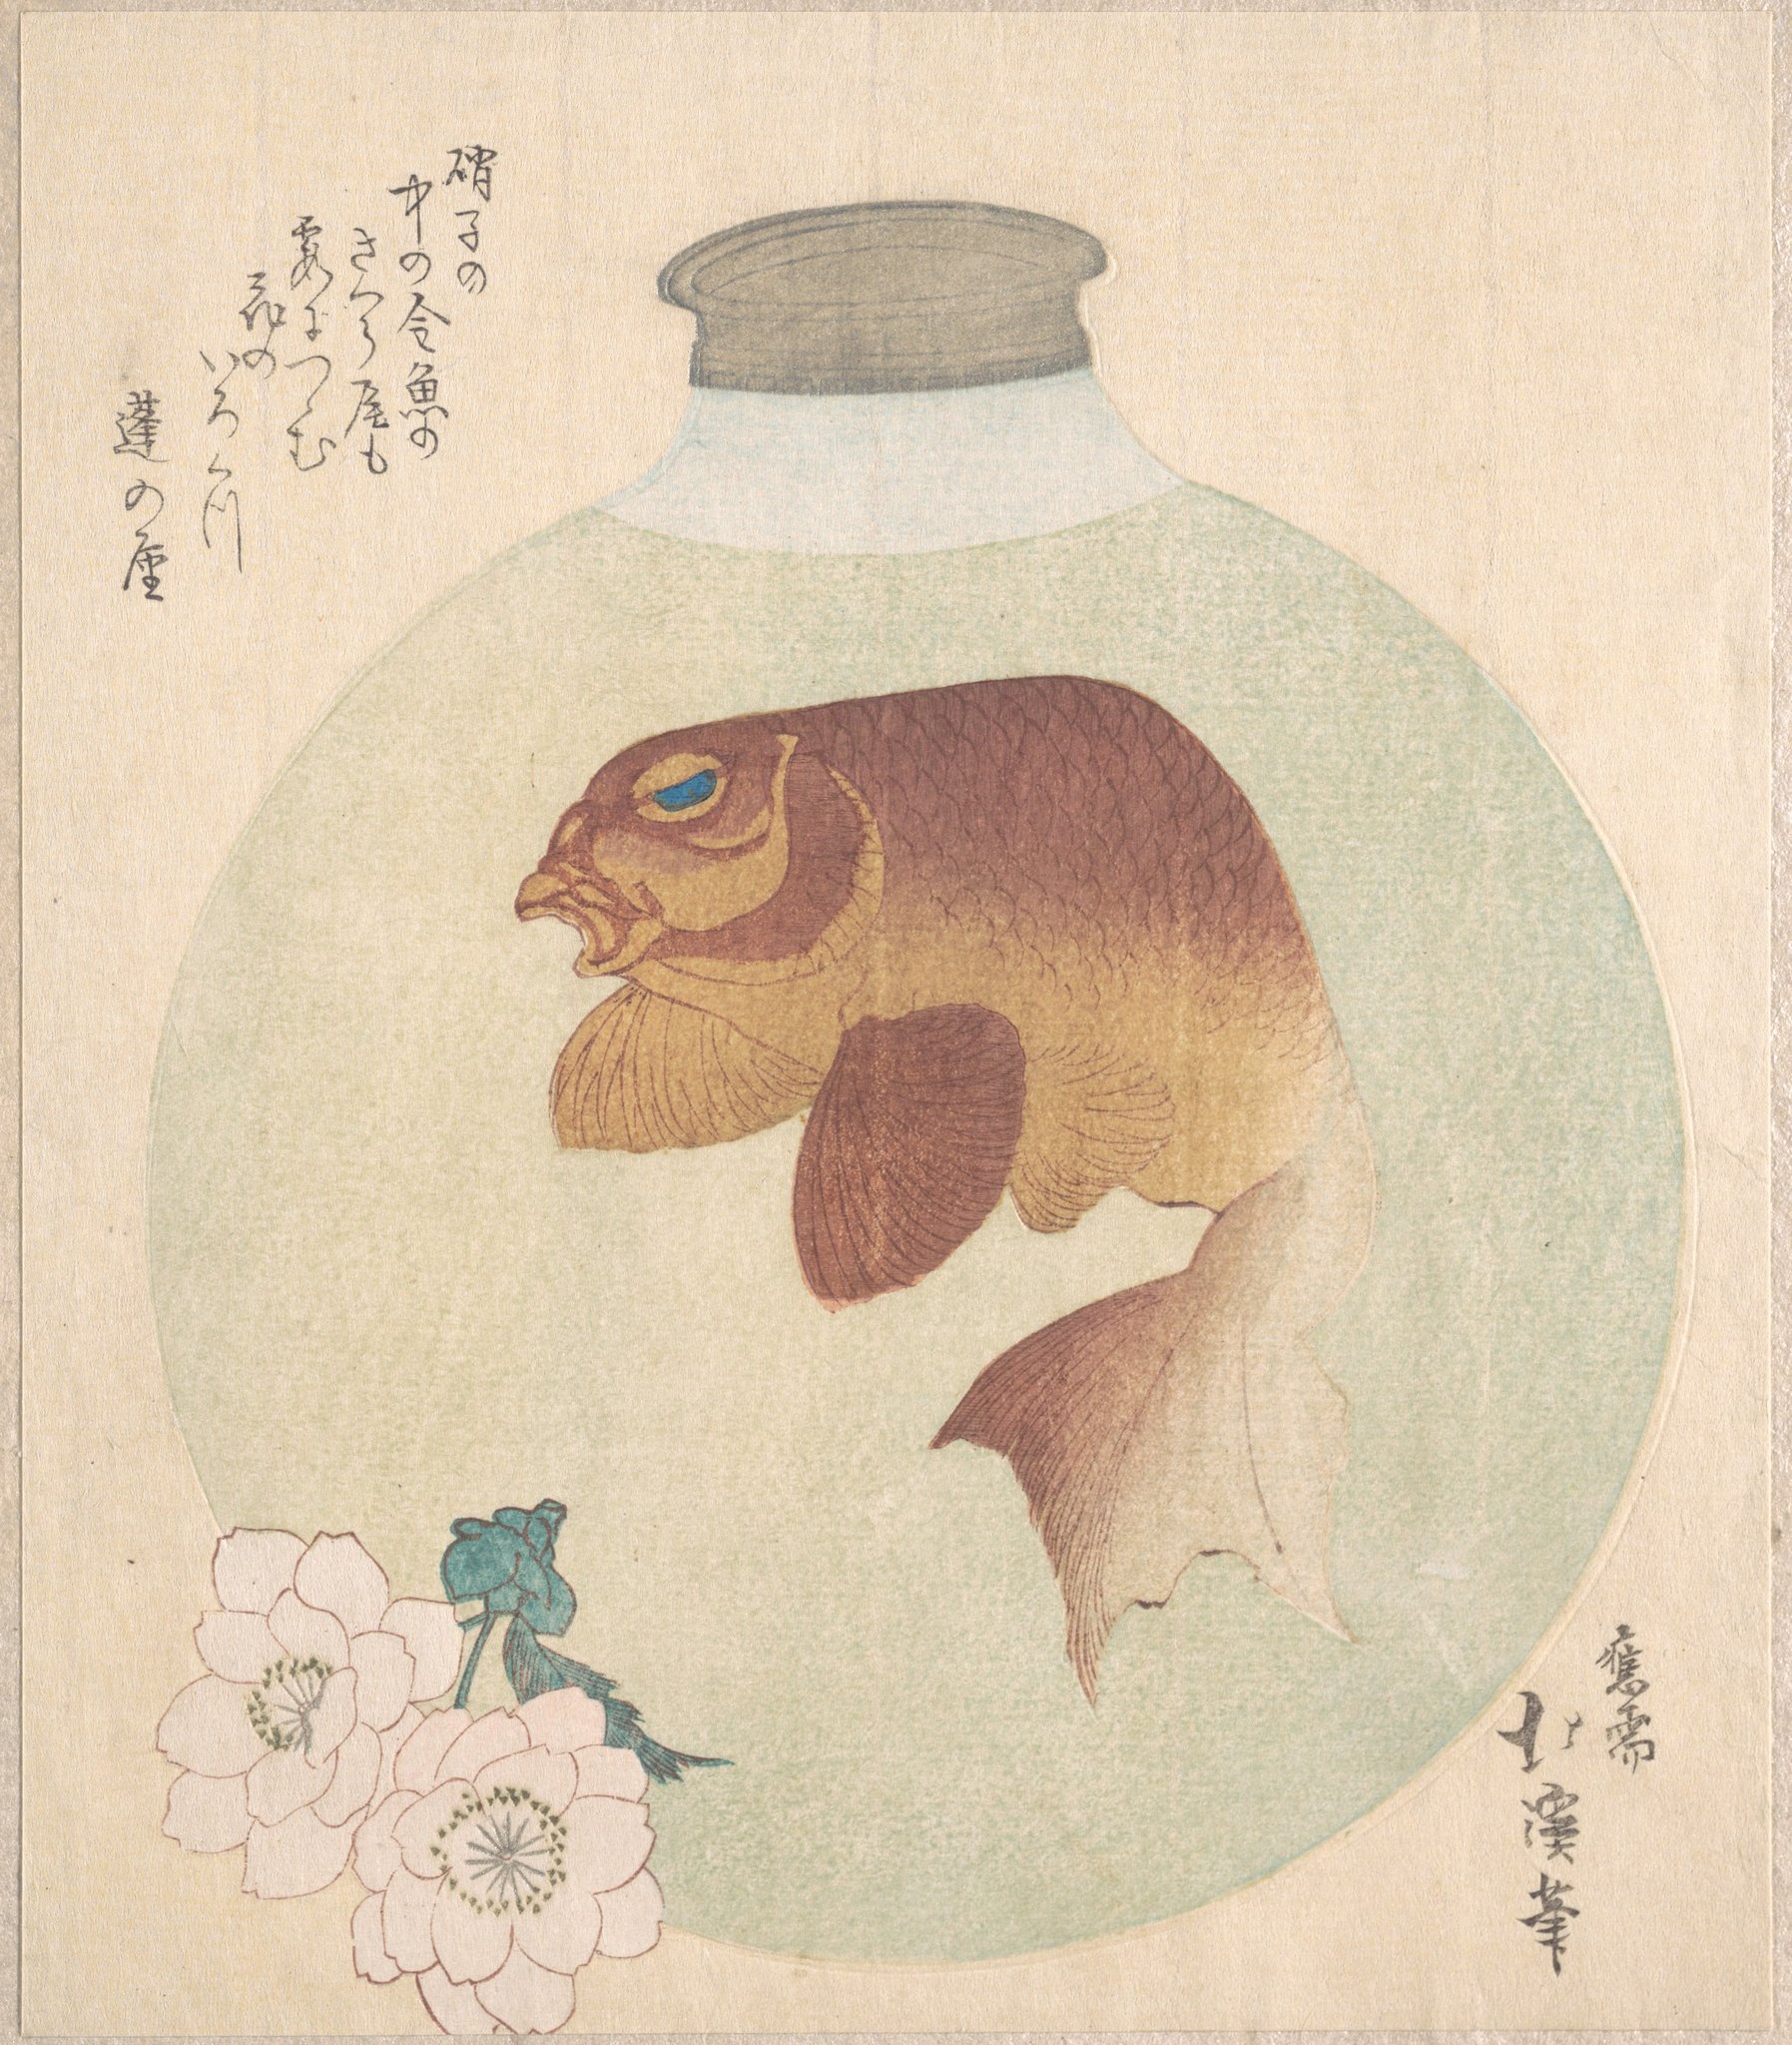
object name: woodblock print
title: Gold-Fish in a Glass Bottle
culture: japanese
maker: totoya hokkei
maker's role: artist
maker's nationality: japanese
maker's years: 1780-1850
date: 1801-1900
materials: ink, paper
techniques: surimono, woodblock print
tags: fish,flowers